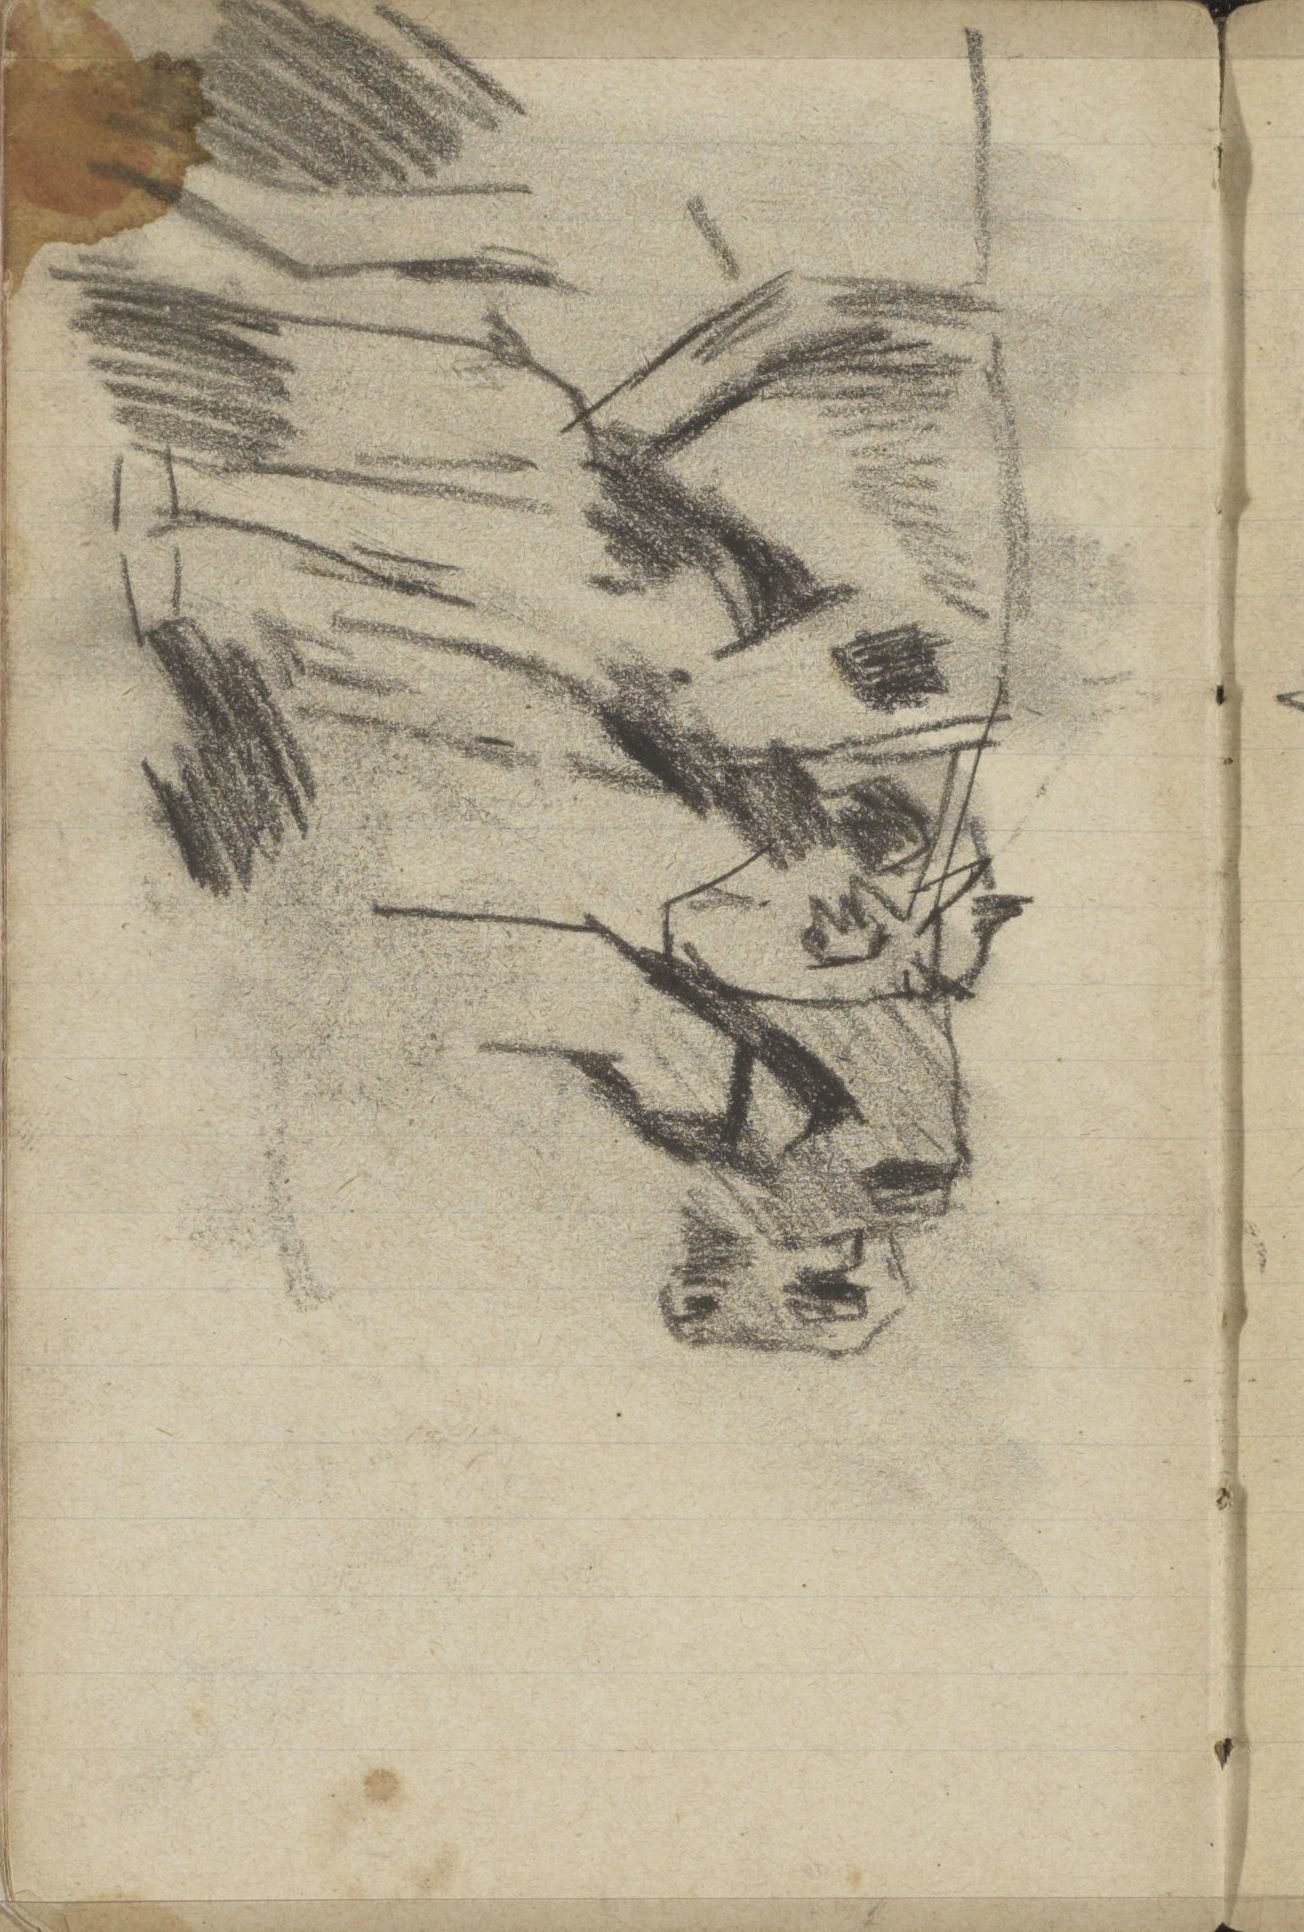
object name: sketchbook leaf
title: Trampaarden op de Dam te Amsterdam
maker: george hendrik breitner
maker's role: draughtsman, painter, print maker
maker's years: 1857-1923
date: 1886-1903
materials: chalk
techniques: stumping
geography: amsterdam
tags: horse, square, place, circus, etc. (+ city(-scape) with figures, staffage)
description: Pagina 79 uit een schetsboek met 41 bladen.